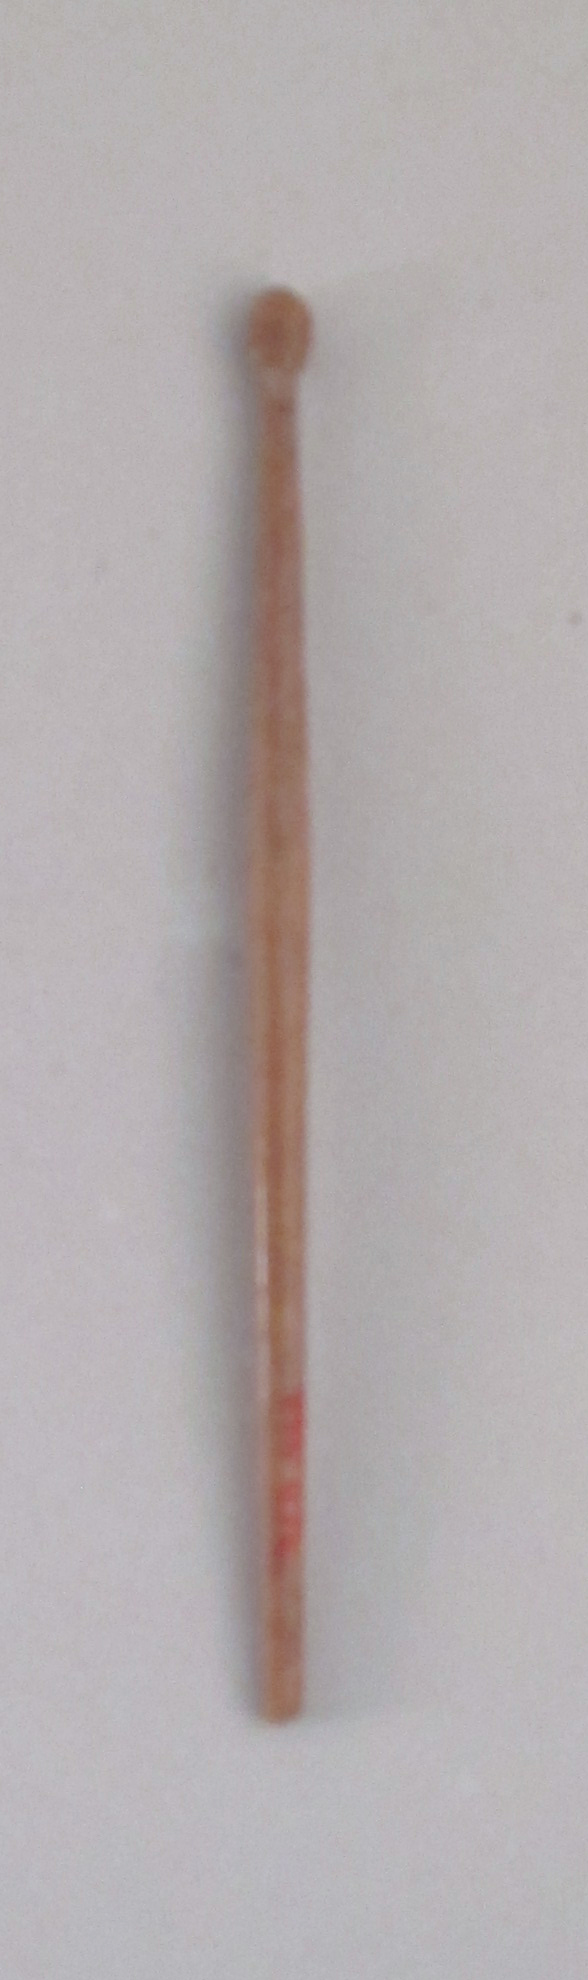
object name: stylus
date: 7000 BCE-330 CE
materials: bone, ivory